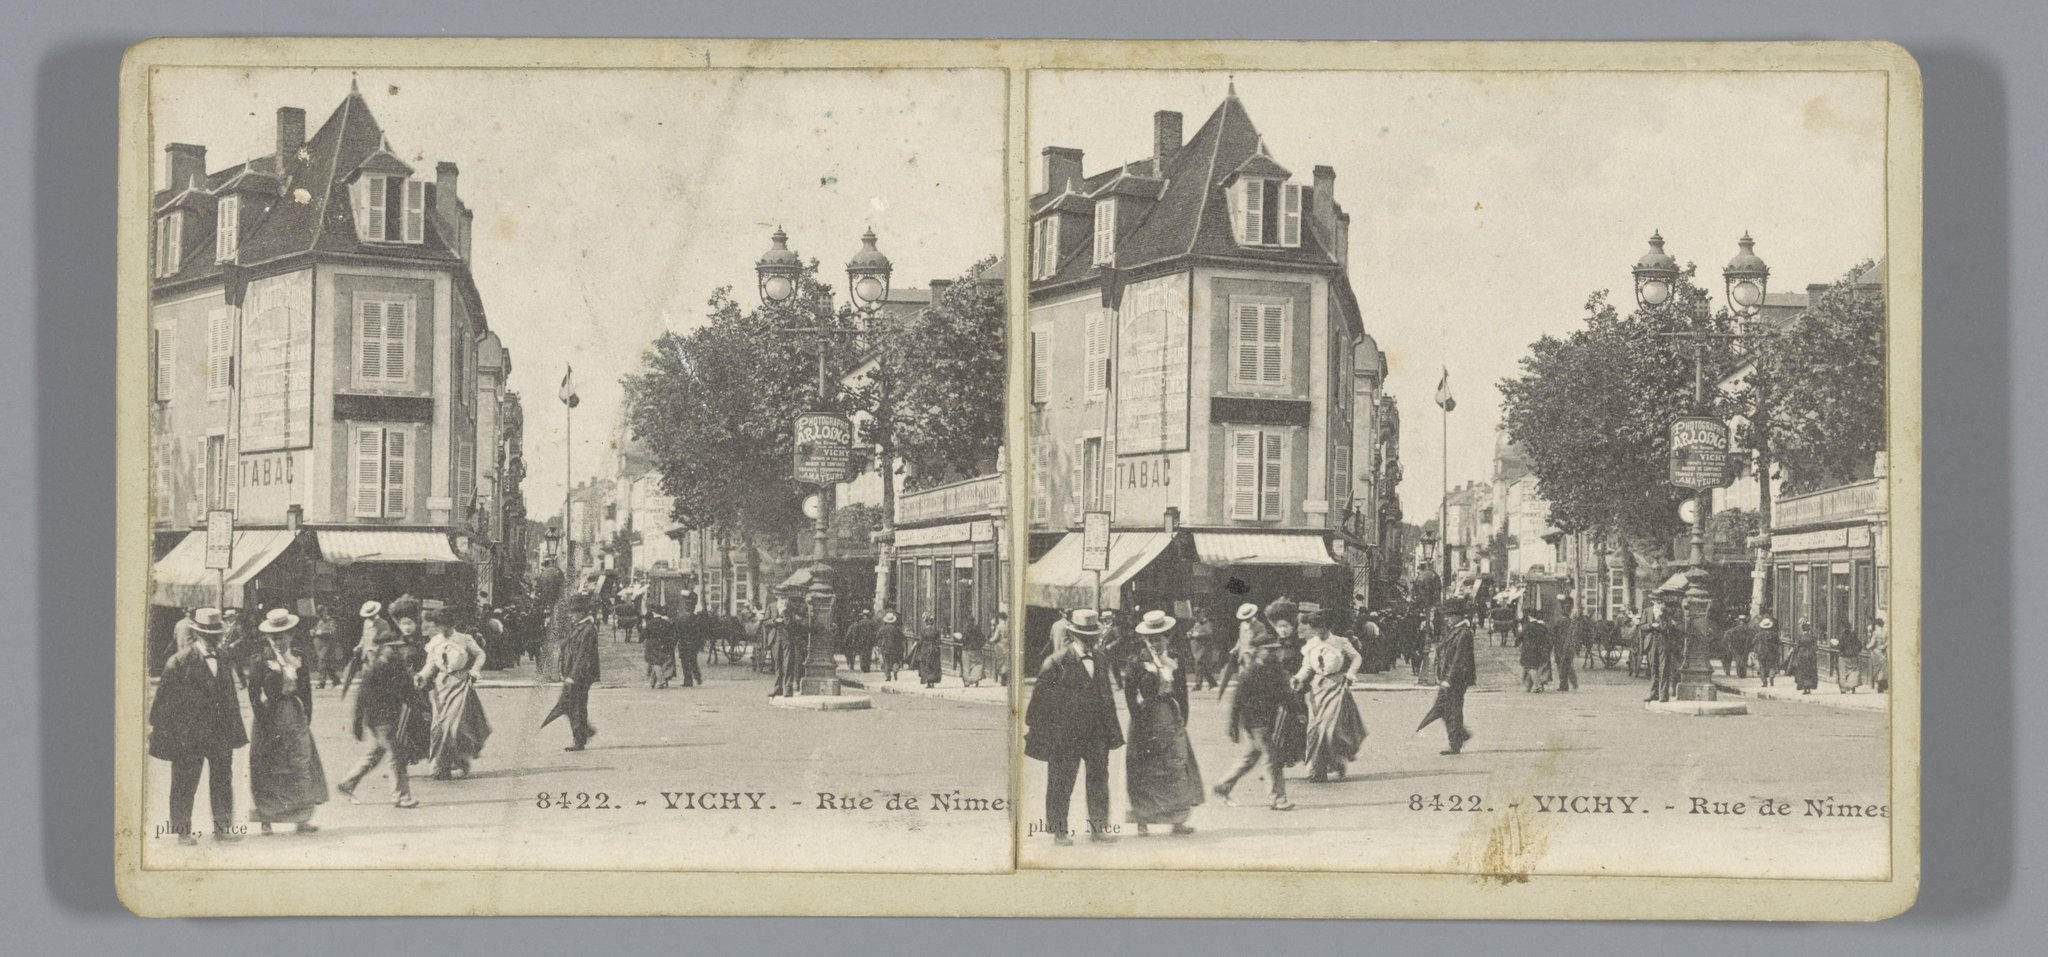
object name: stereograph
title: Gezicht op de Passage de Nîmes in Vichy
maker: Anonymous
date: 1890-1910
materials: cardboard, paper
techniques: photograph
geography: vichy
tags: advertisement, notice, street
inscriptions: number: ‘8422’, name: ‘[...] phot, Nice’